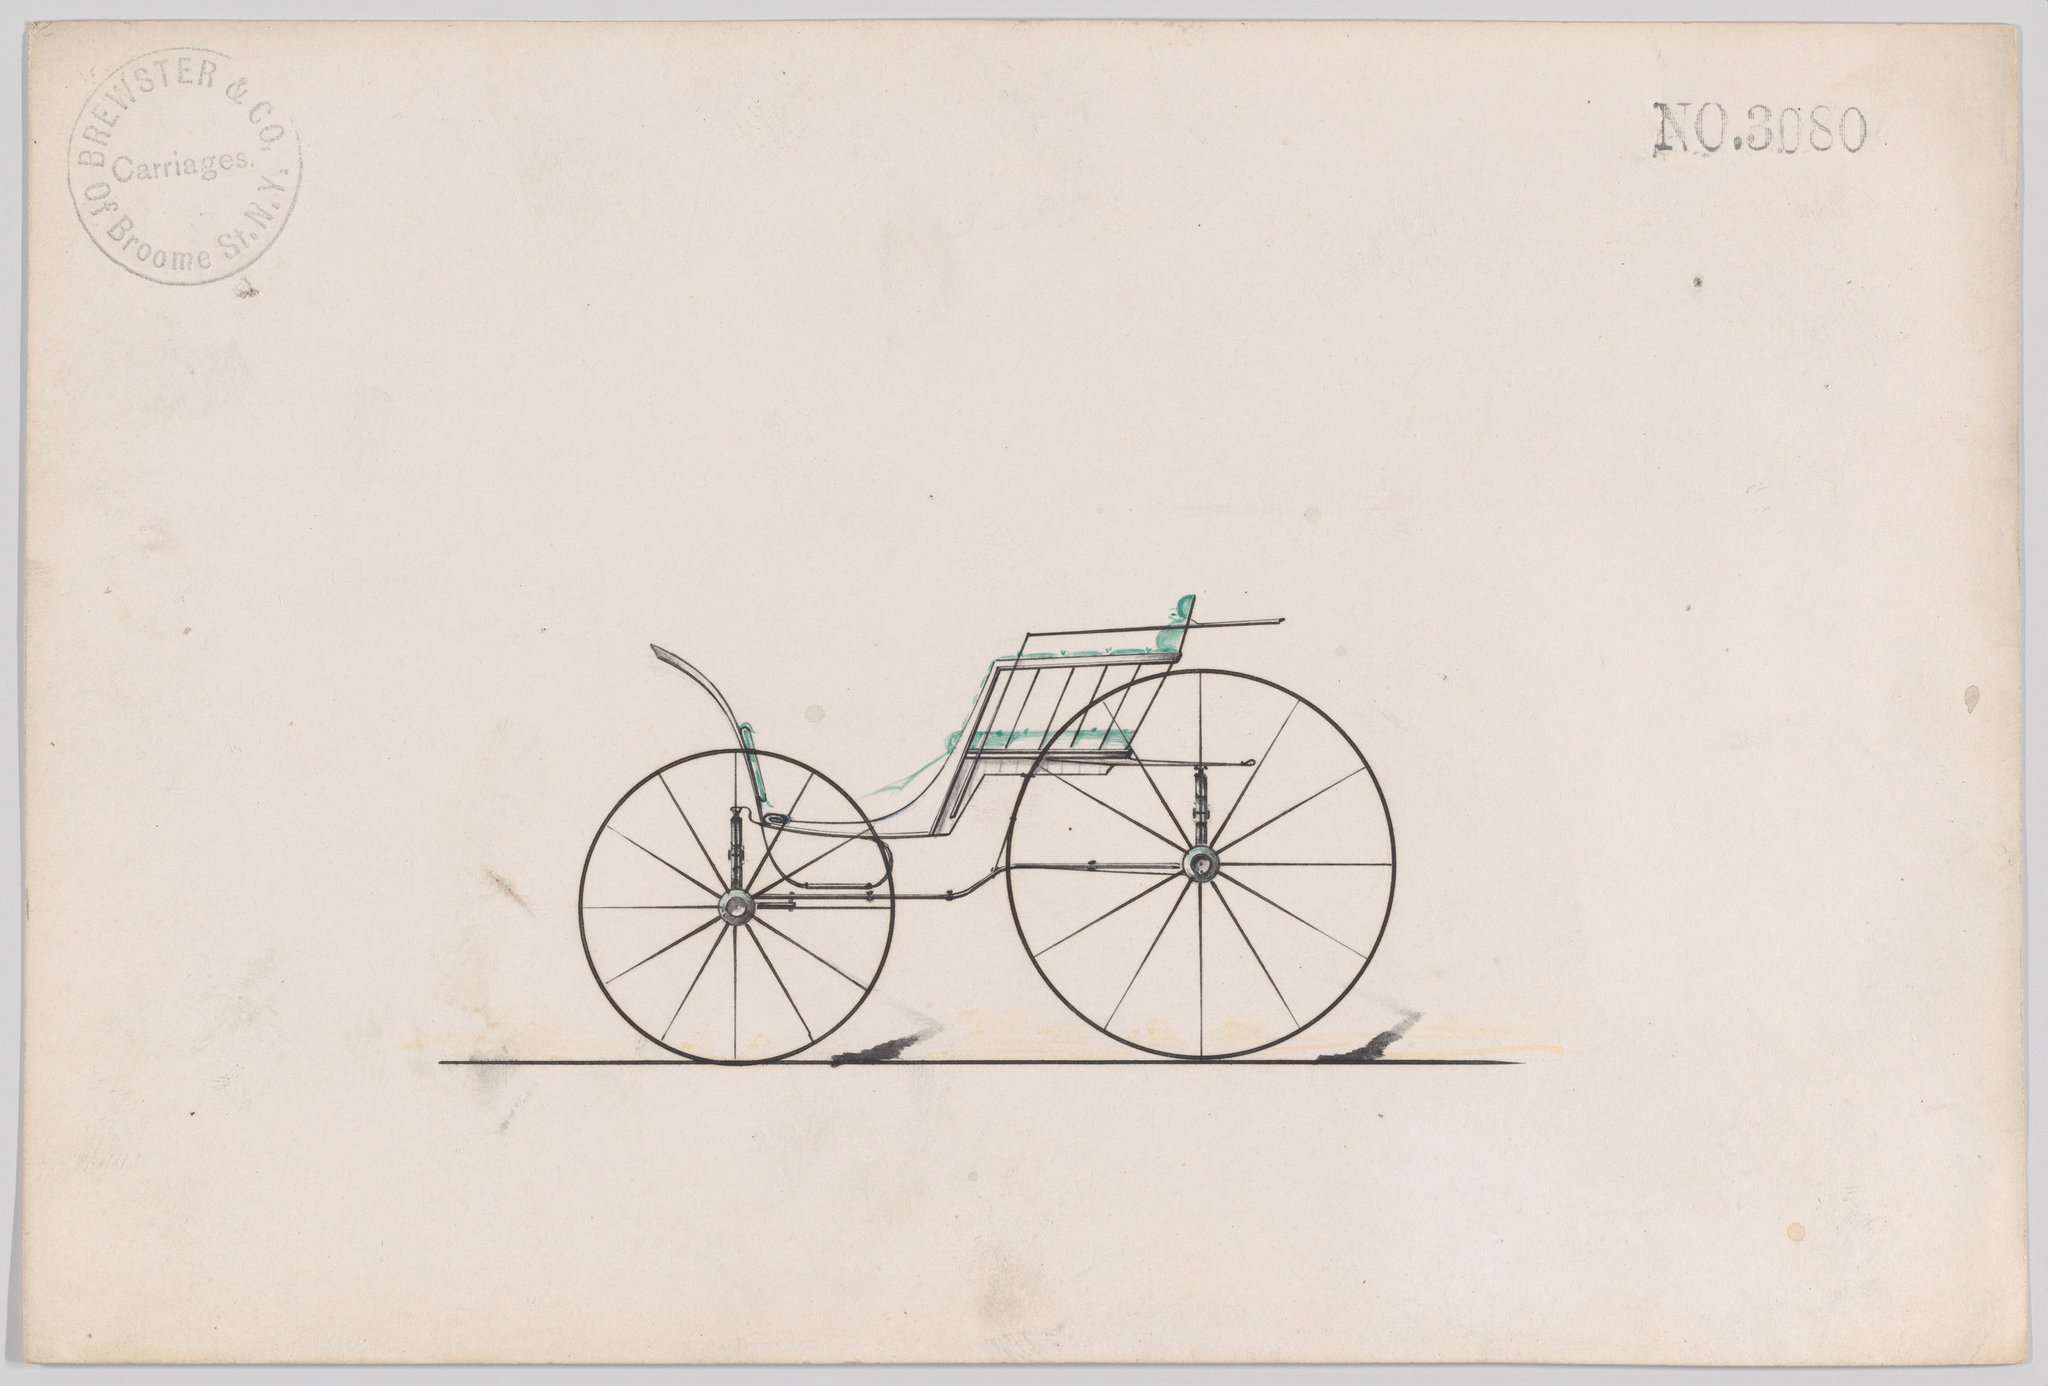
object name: drawing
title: Design for Pony Phaeton, no. 3080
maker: brewster & co.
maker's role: manufacturer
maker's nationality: american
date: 1874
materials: gouache, ink, watercolor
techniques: pen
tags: carriages